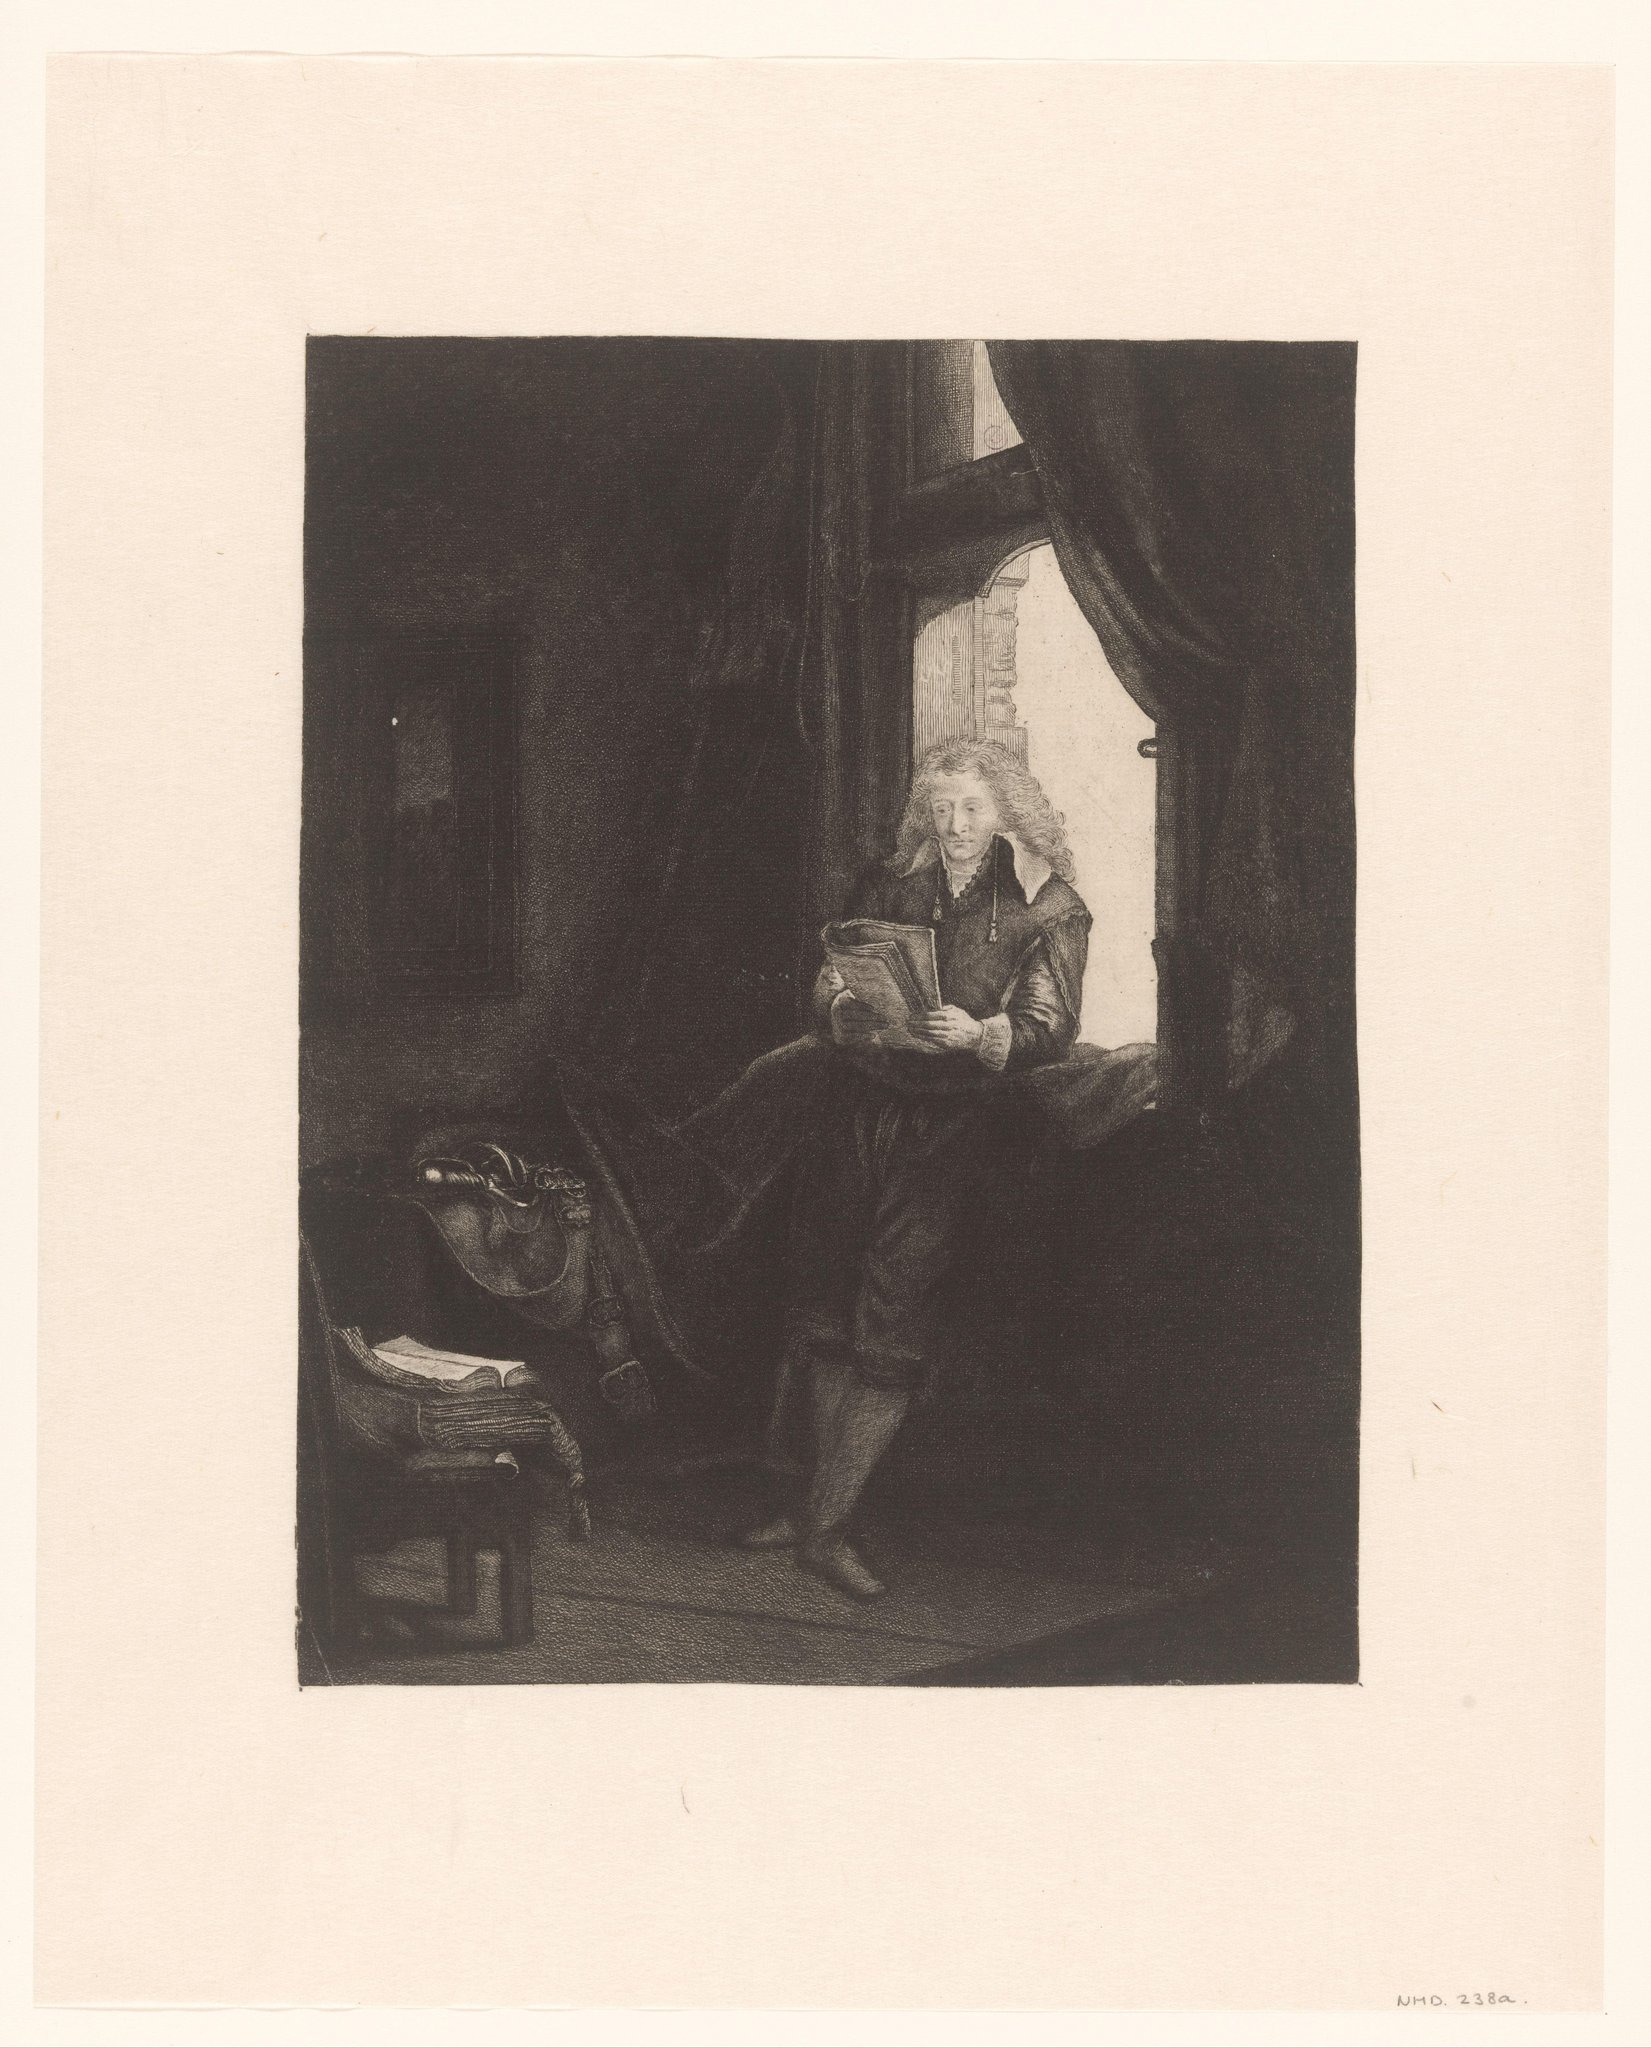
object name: print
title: Jan Six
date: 1733-1797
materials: paper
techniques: etching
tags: amsterdam, jan six (1618-1700), historical persons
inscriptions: collector's mark: Lugt 2760, collector's mark: Lugt 720a, collector's mark: Lugt 2228